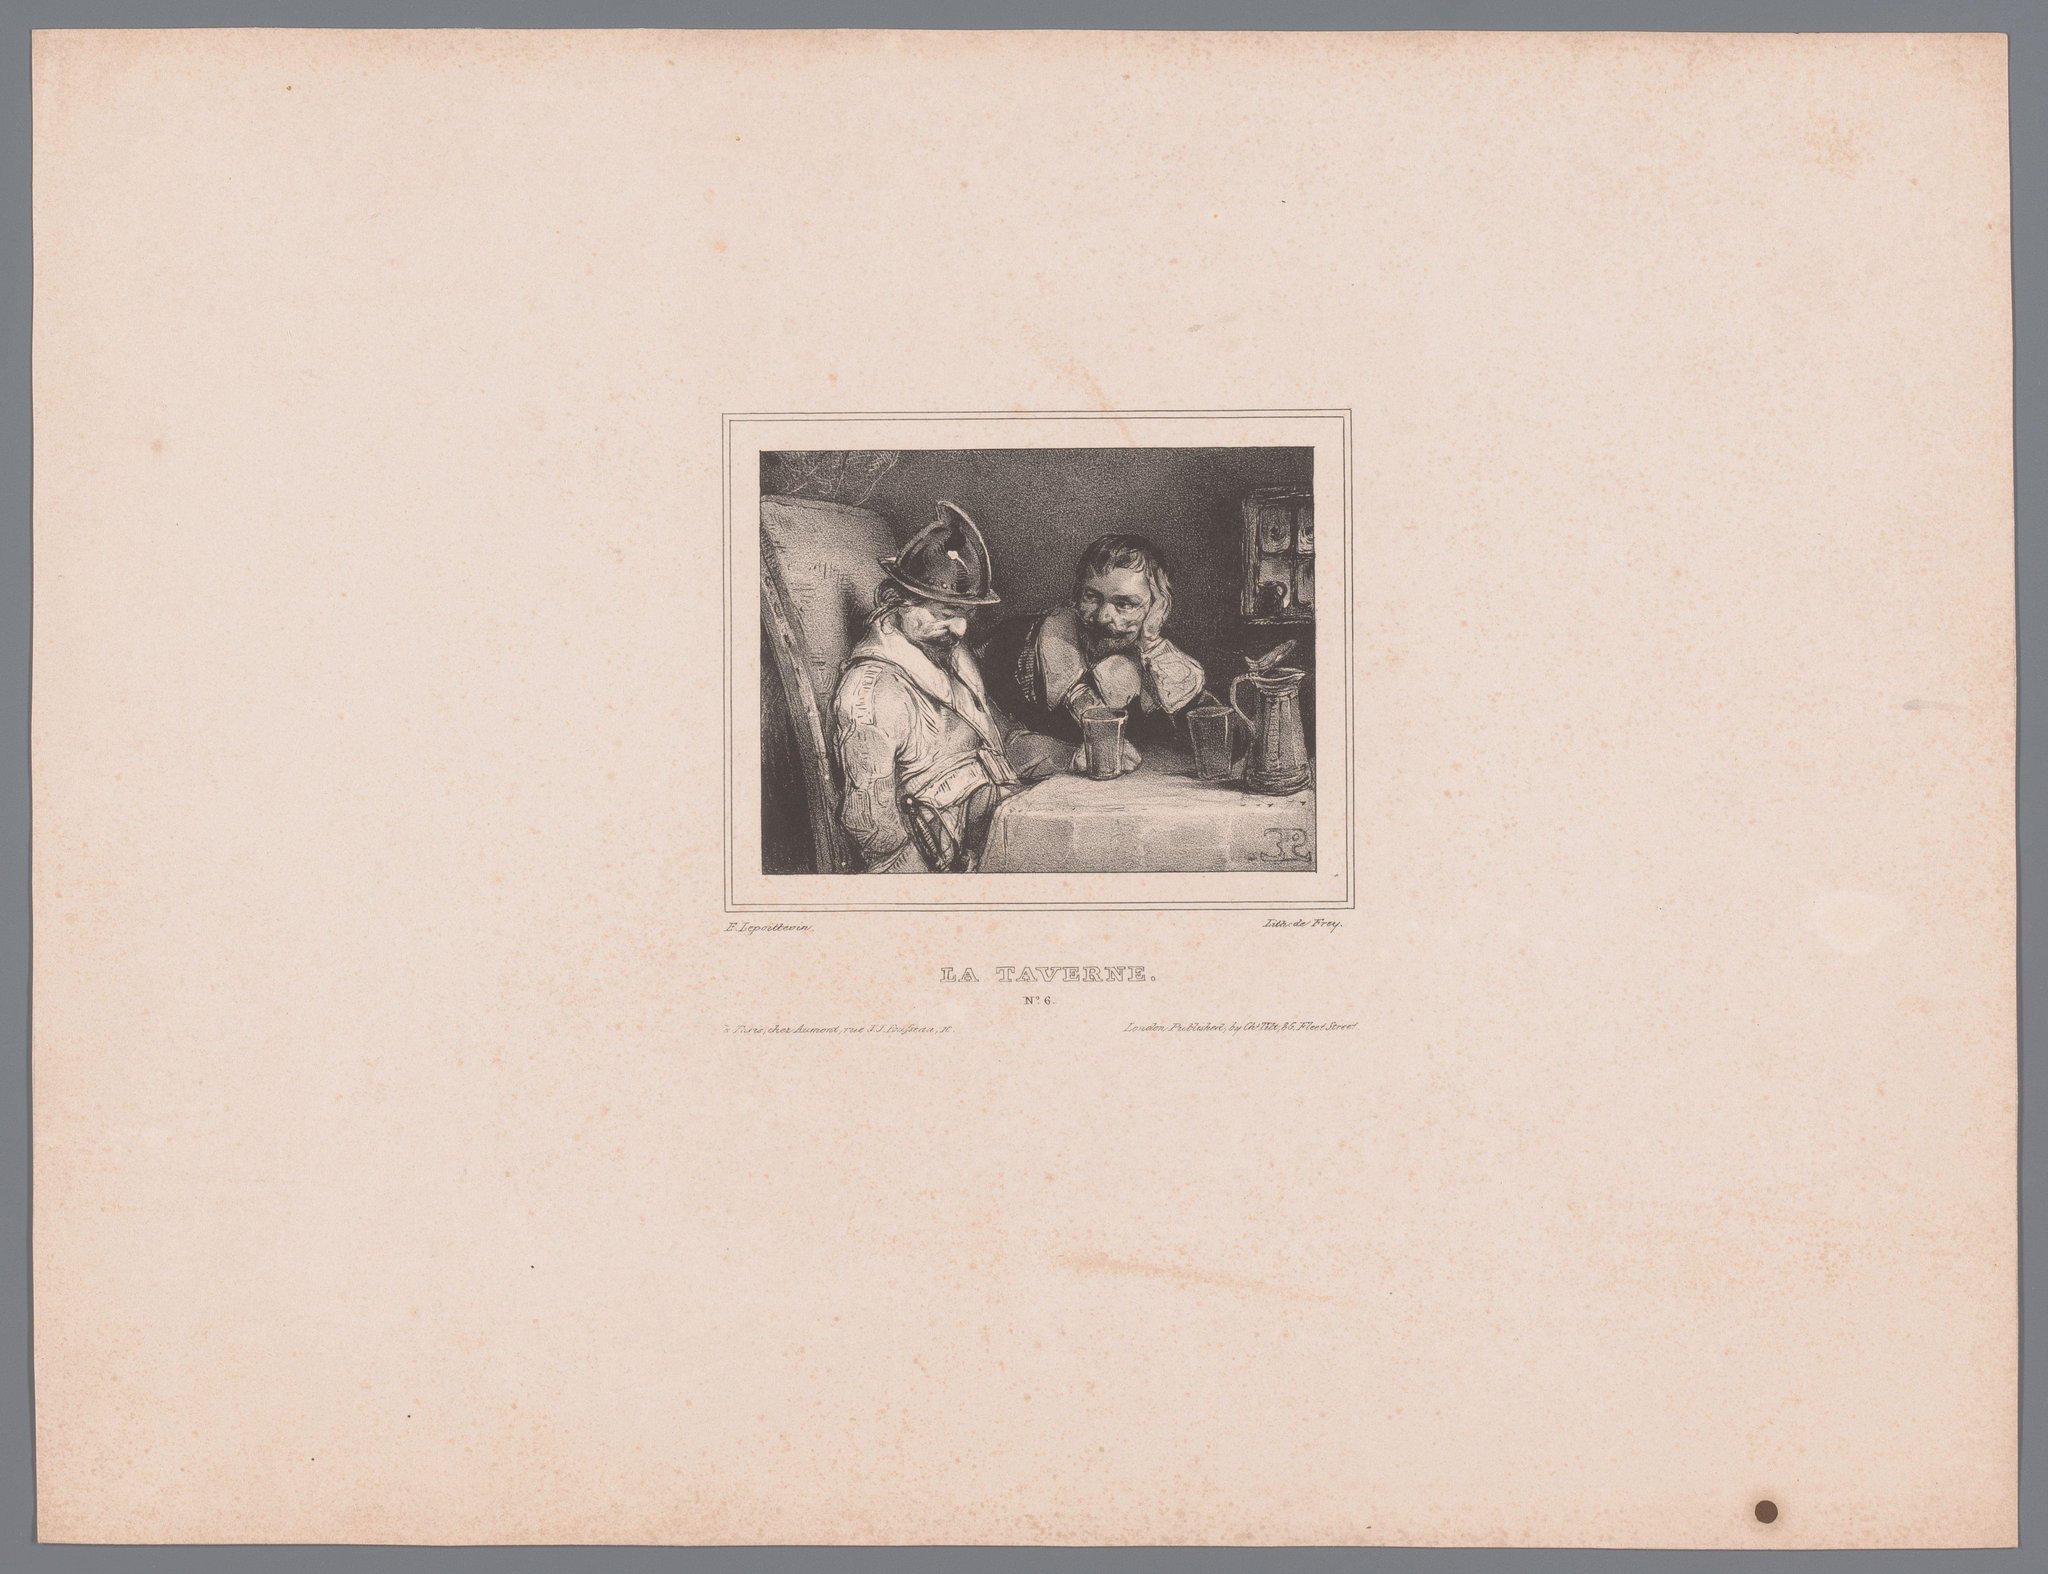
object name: print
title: Twee soldaten in een herberg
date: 1832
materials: paper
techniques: lithograph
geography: paris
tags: sleeping in chair, canteen ~ the soldier off duty, inn, coffee-house, public house, etc., alcoholic drinks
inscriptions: collector's mark: Lugt 2228a